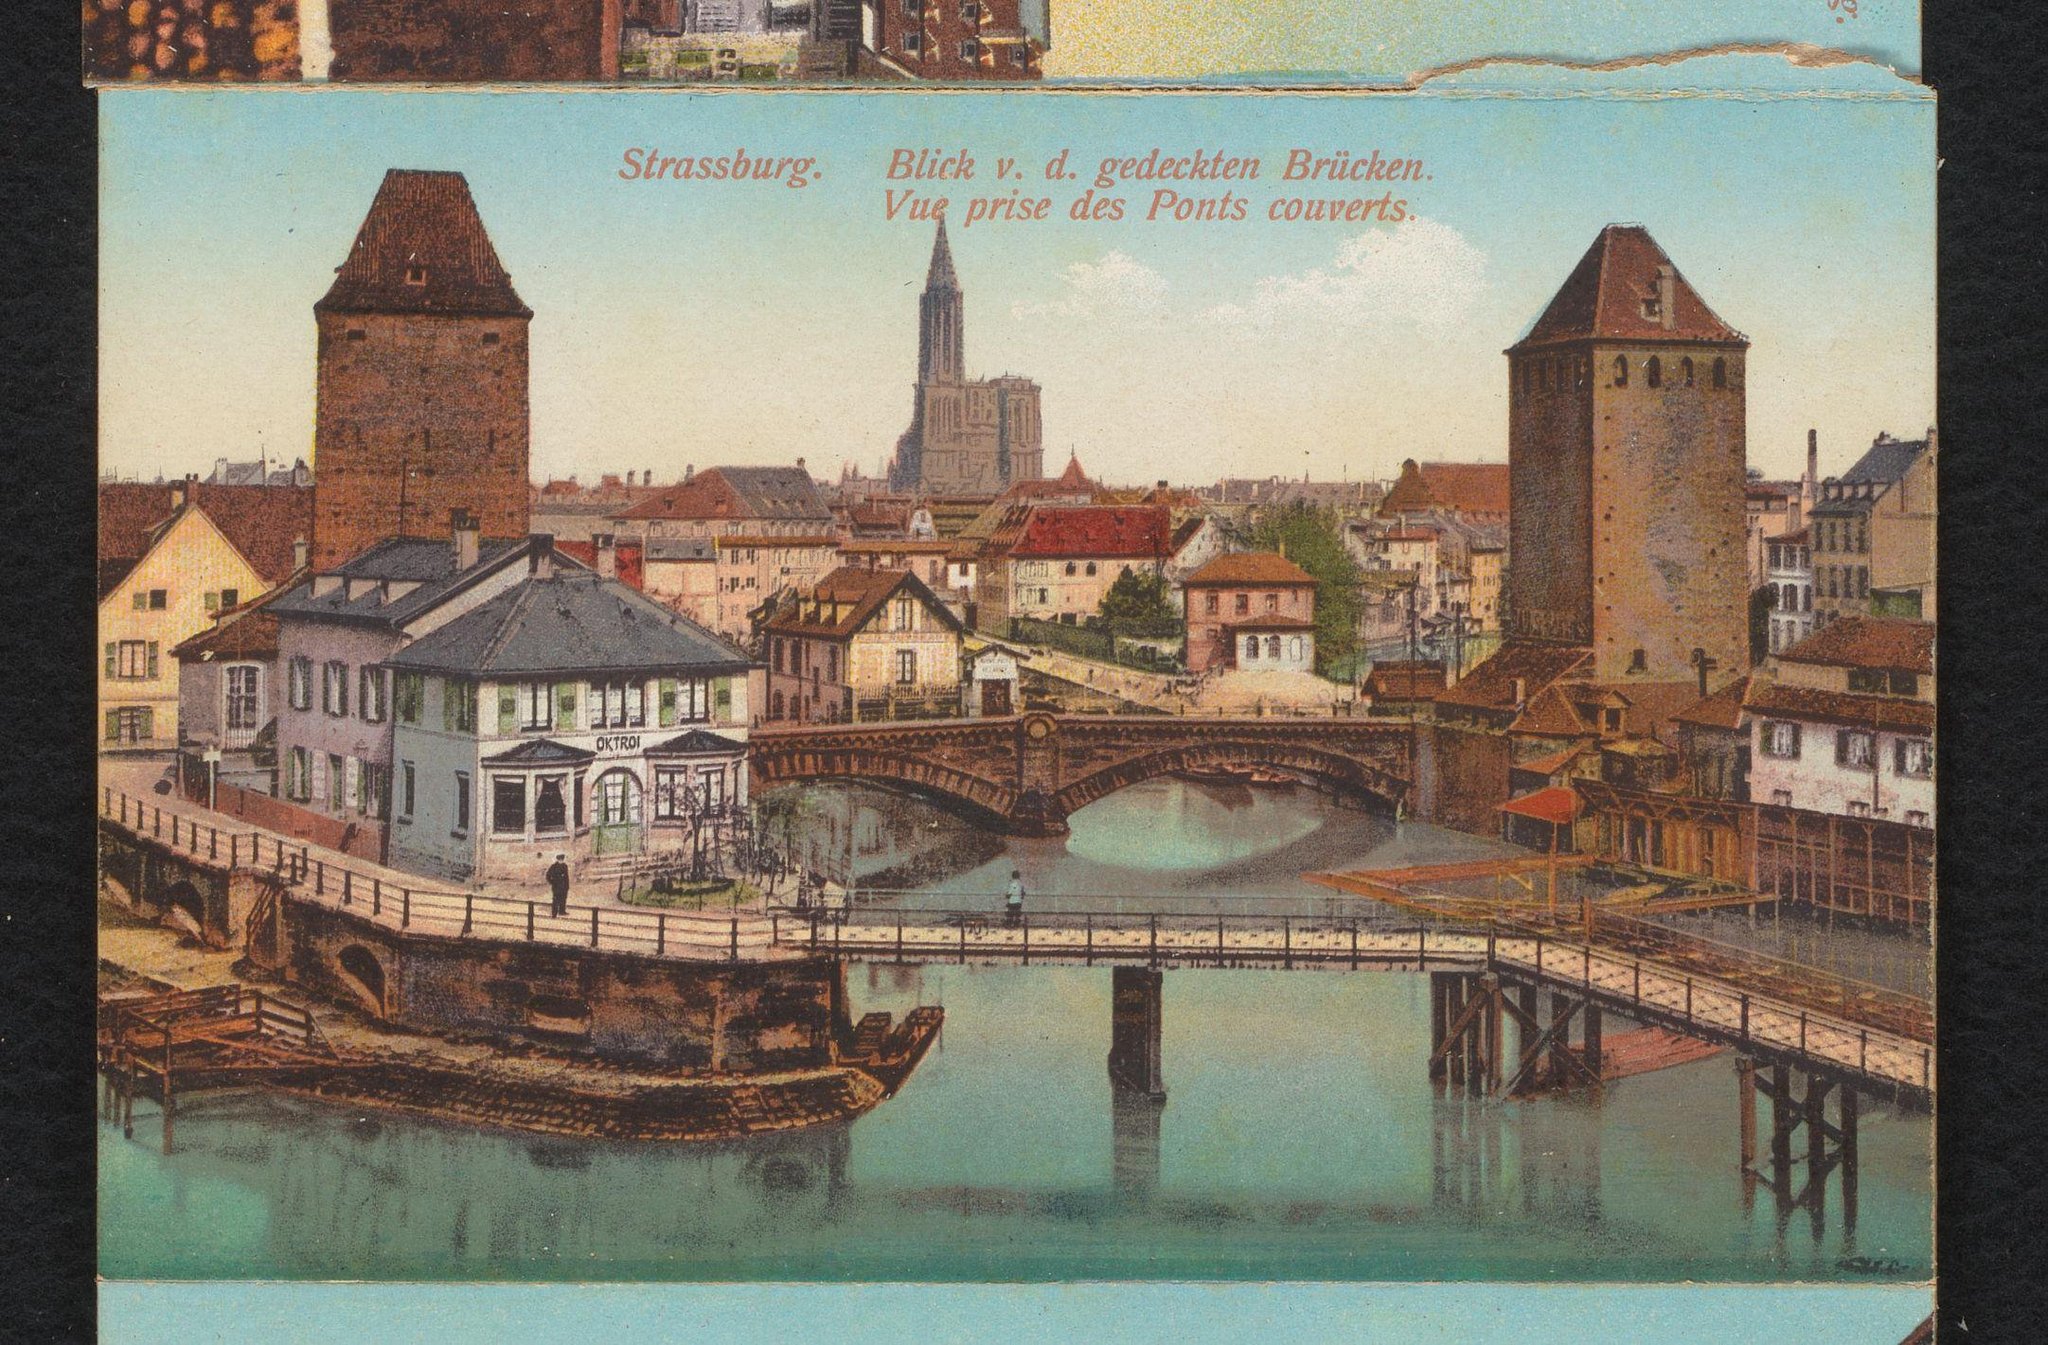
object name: photomechanical print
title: Strassburg. Blick v. d. gedeckten Brücken / Vue prise des Ponts couverts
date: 1905-1930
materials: cardboard, photographic process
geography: straatsburg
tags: city-view, and landscape with man-made constructions, canals, waters (in city), bridge in city across river, canal, etc.